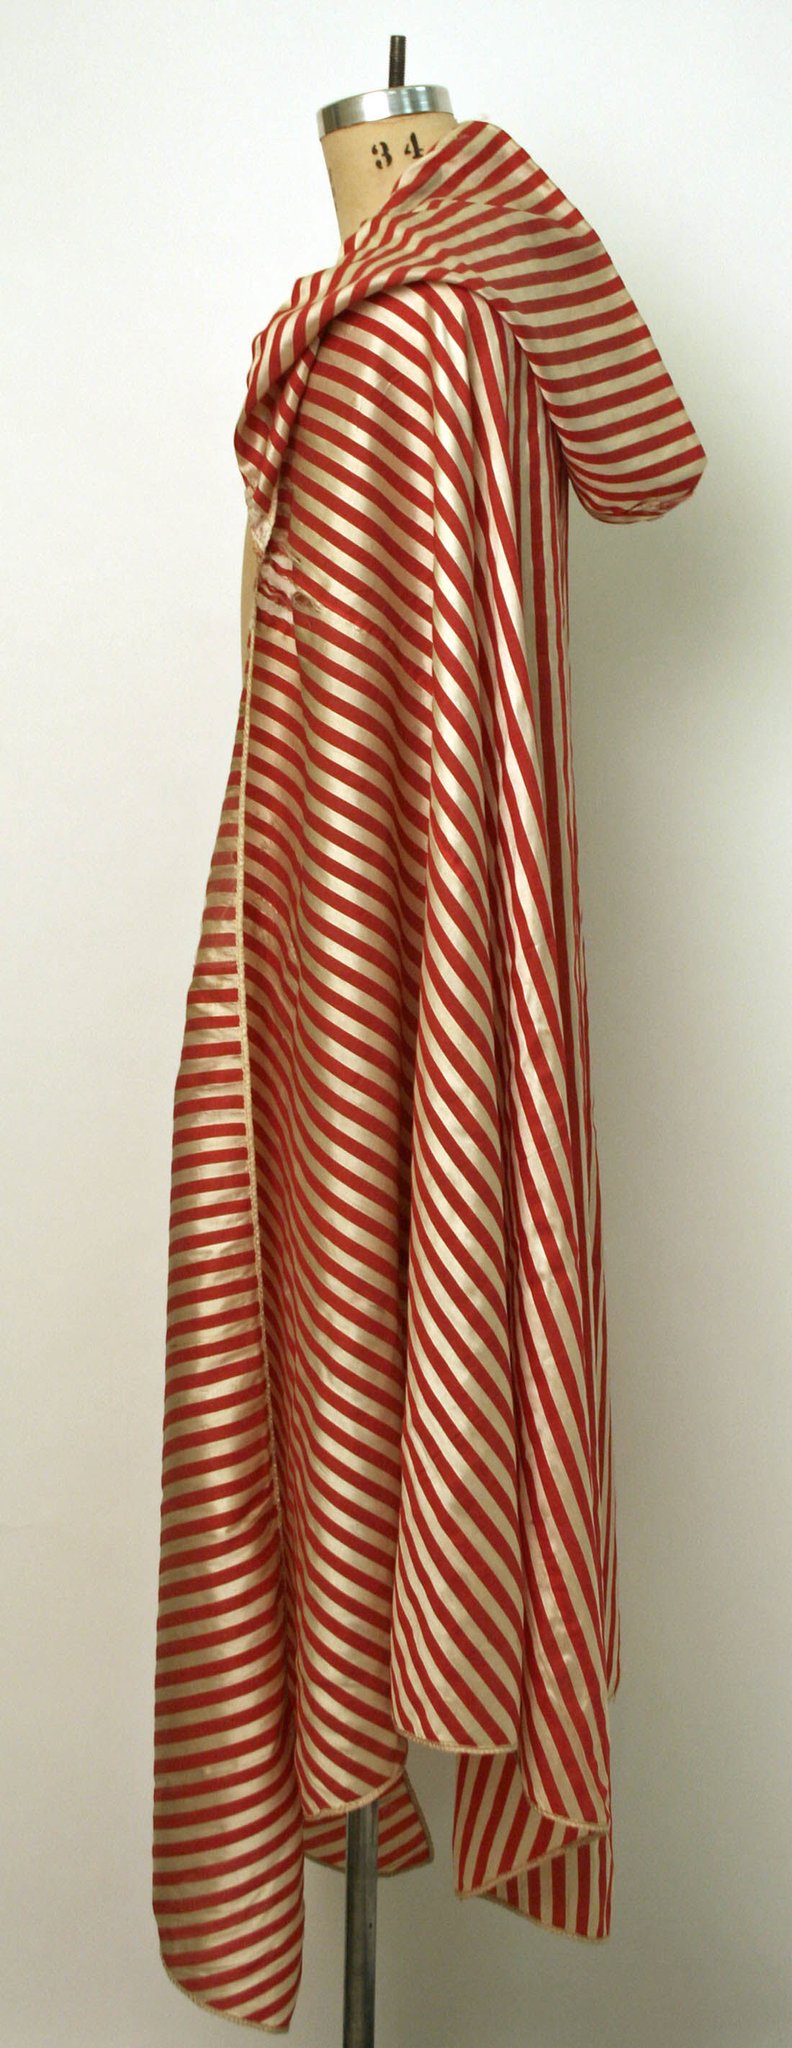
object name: burnus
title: Burnus / Selham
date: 1801-1900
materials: silk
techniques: weave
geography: algeria